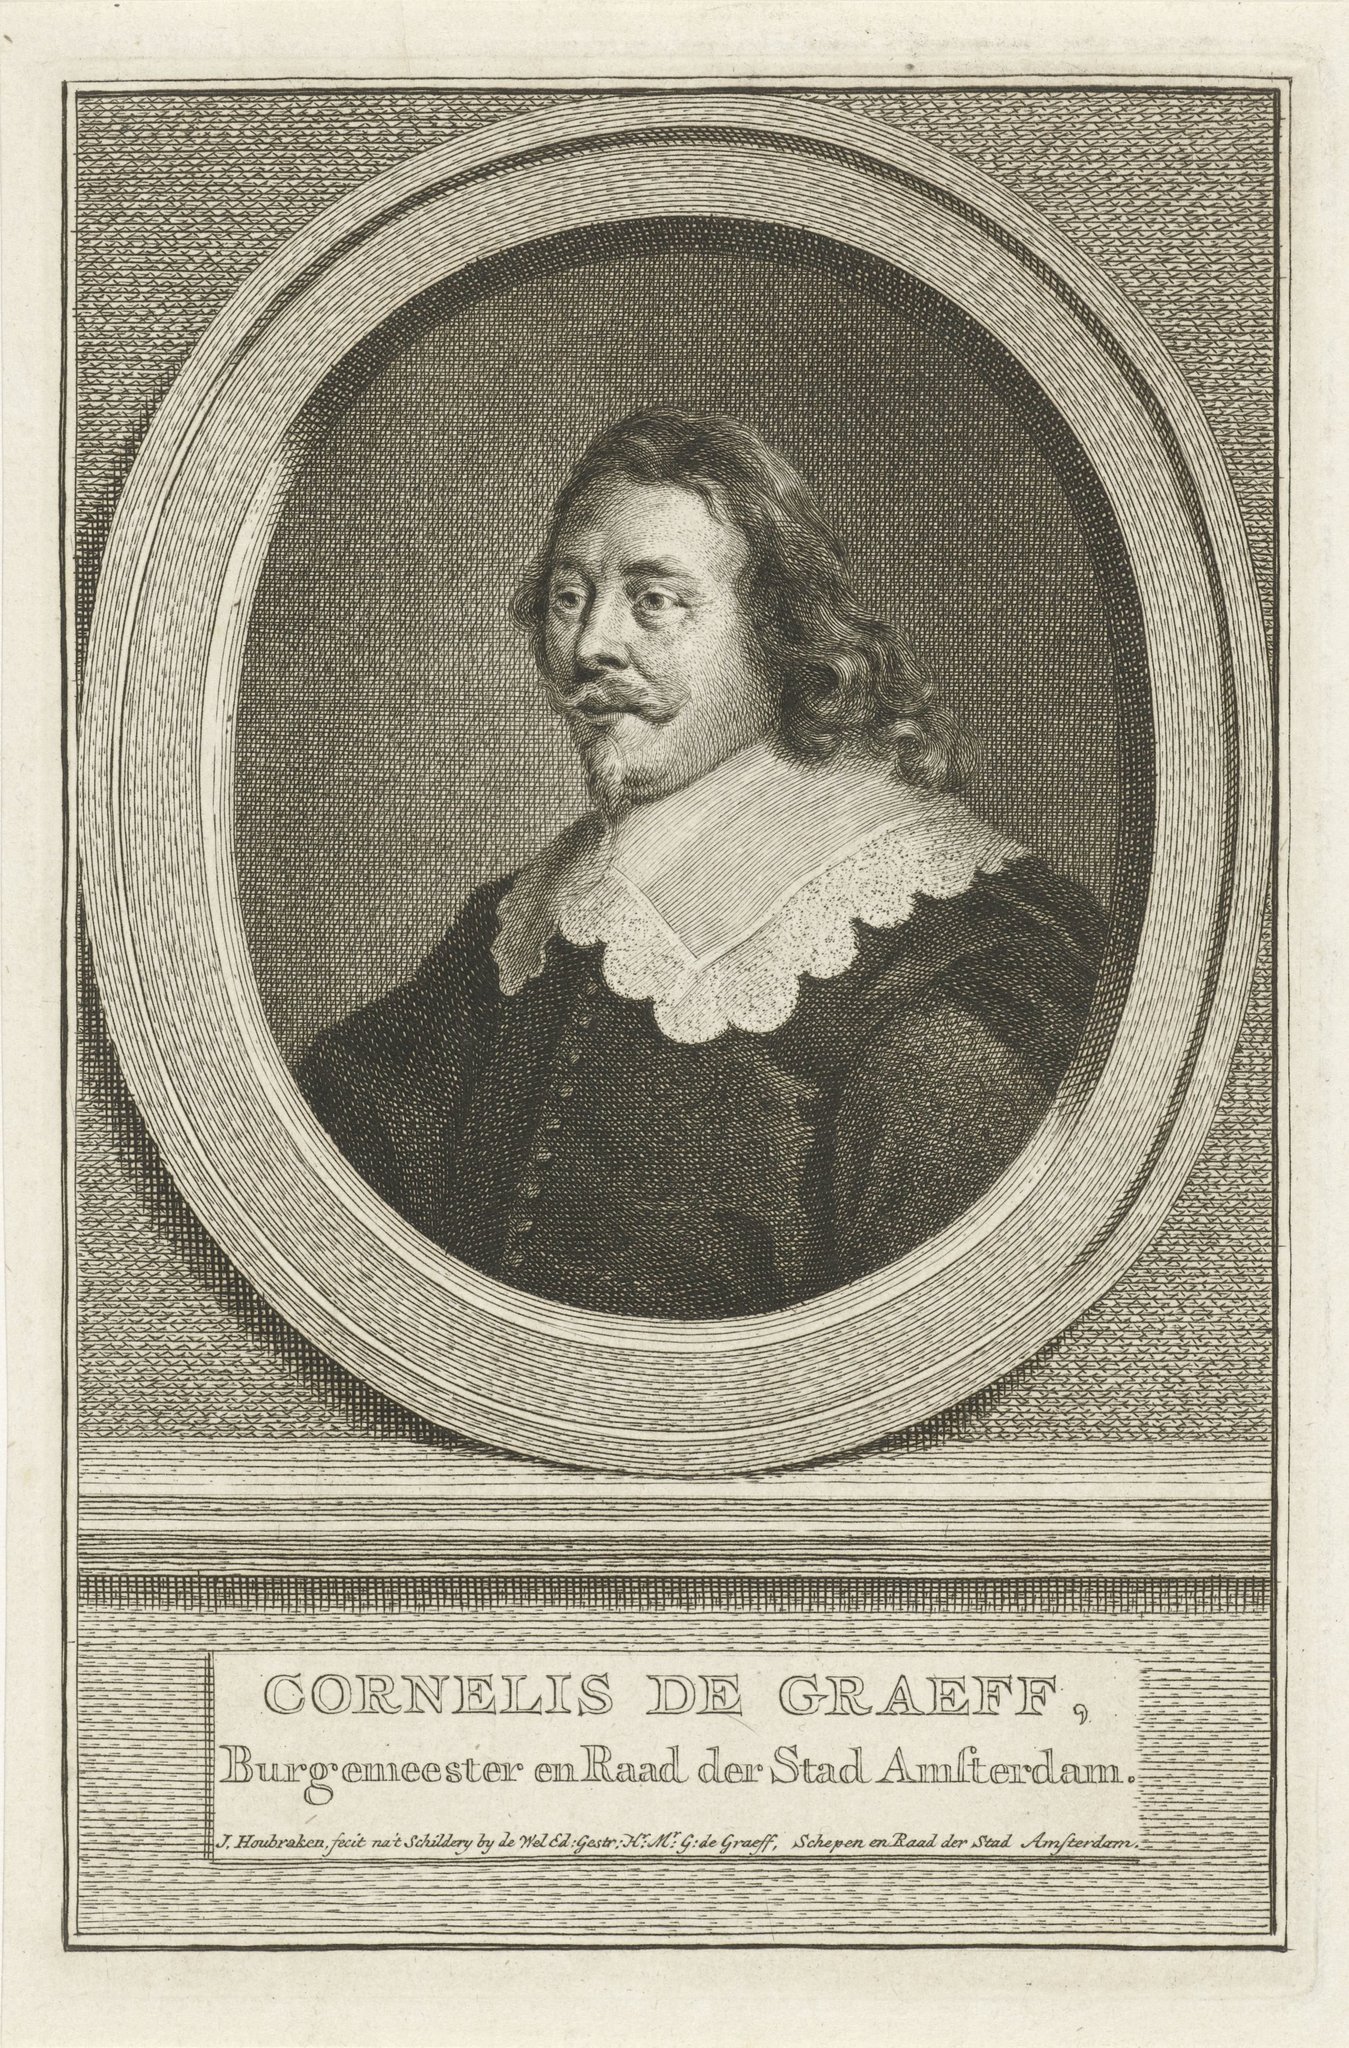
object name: print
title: Portret van Cornelis de Graeff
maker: jacob houbraken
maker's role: draughtsman, print maker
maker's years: 1698-1780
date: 1749-1780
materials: paper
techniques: engraving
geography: amsterdam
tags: cornelis de graeff, historical persons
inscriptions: collector's mark: Lugt 2228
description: Deze prent is oorspronkelijk bedoeld als aanvulling op Jan Wagenaars ‘Vaderlandsche historie’* en was zo vanaf 1796 verkrijgbaar bij Johannes Allart te Amsterdam. Voor de advertentie waarin Allart de 60 portretten en 7 platen, allen gegraveerd door Houbraken, ter aanvulling op Wagenaars ‘Vaderlandsche historie’ aanbiedt, zie RP-P-OB-77.766. *Van dit werk zijn in de achttiende eeuw meerdere uitgaves verschenen, zoals: Wagenaar, Jan. Vaderlandsche historie, vervattende de geschiedenissen der Vereenigde Nederlanden (…). 21 delen. Amsterdam: Isaak Tirion, 1749-1759. Wagenaar, Jan. Vaderlandsche historie, vervattende de geschiedenissen der nu Vereenigde Nederlanden (…). 21 delen. Amsterdam: weduwe Isaak Tirion, 1770. Wagenaar, Jan. Vaderlandsche historie, vervattende de geschiedenissen der nu Vereenigde Nederlanden (…). 21 delen. Amsterdam, Leiden, Dordrecht en Harlingen: P. Schouten e.a., 1782. Wagenaar, Jan. Vaderlandsche historie, vervattende de geschiedenissen der nu Vereenigde Nederlanden (…). 21 delen. Amsterdam: Johannes Allart, 1790-1796.